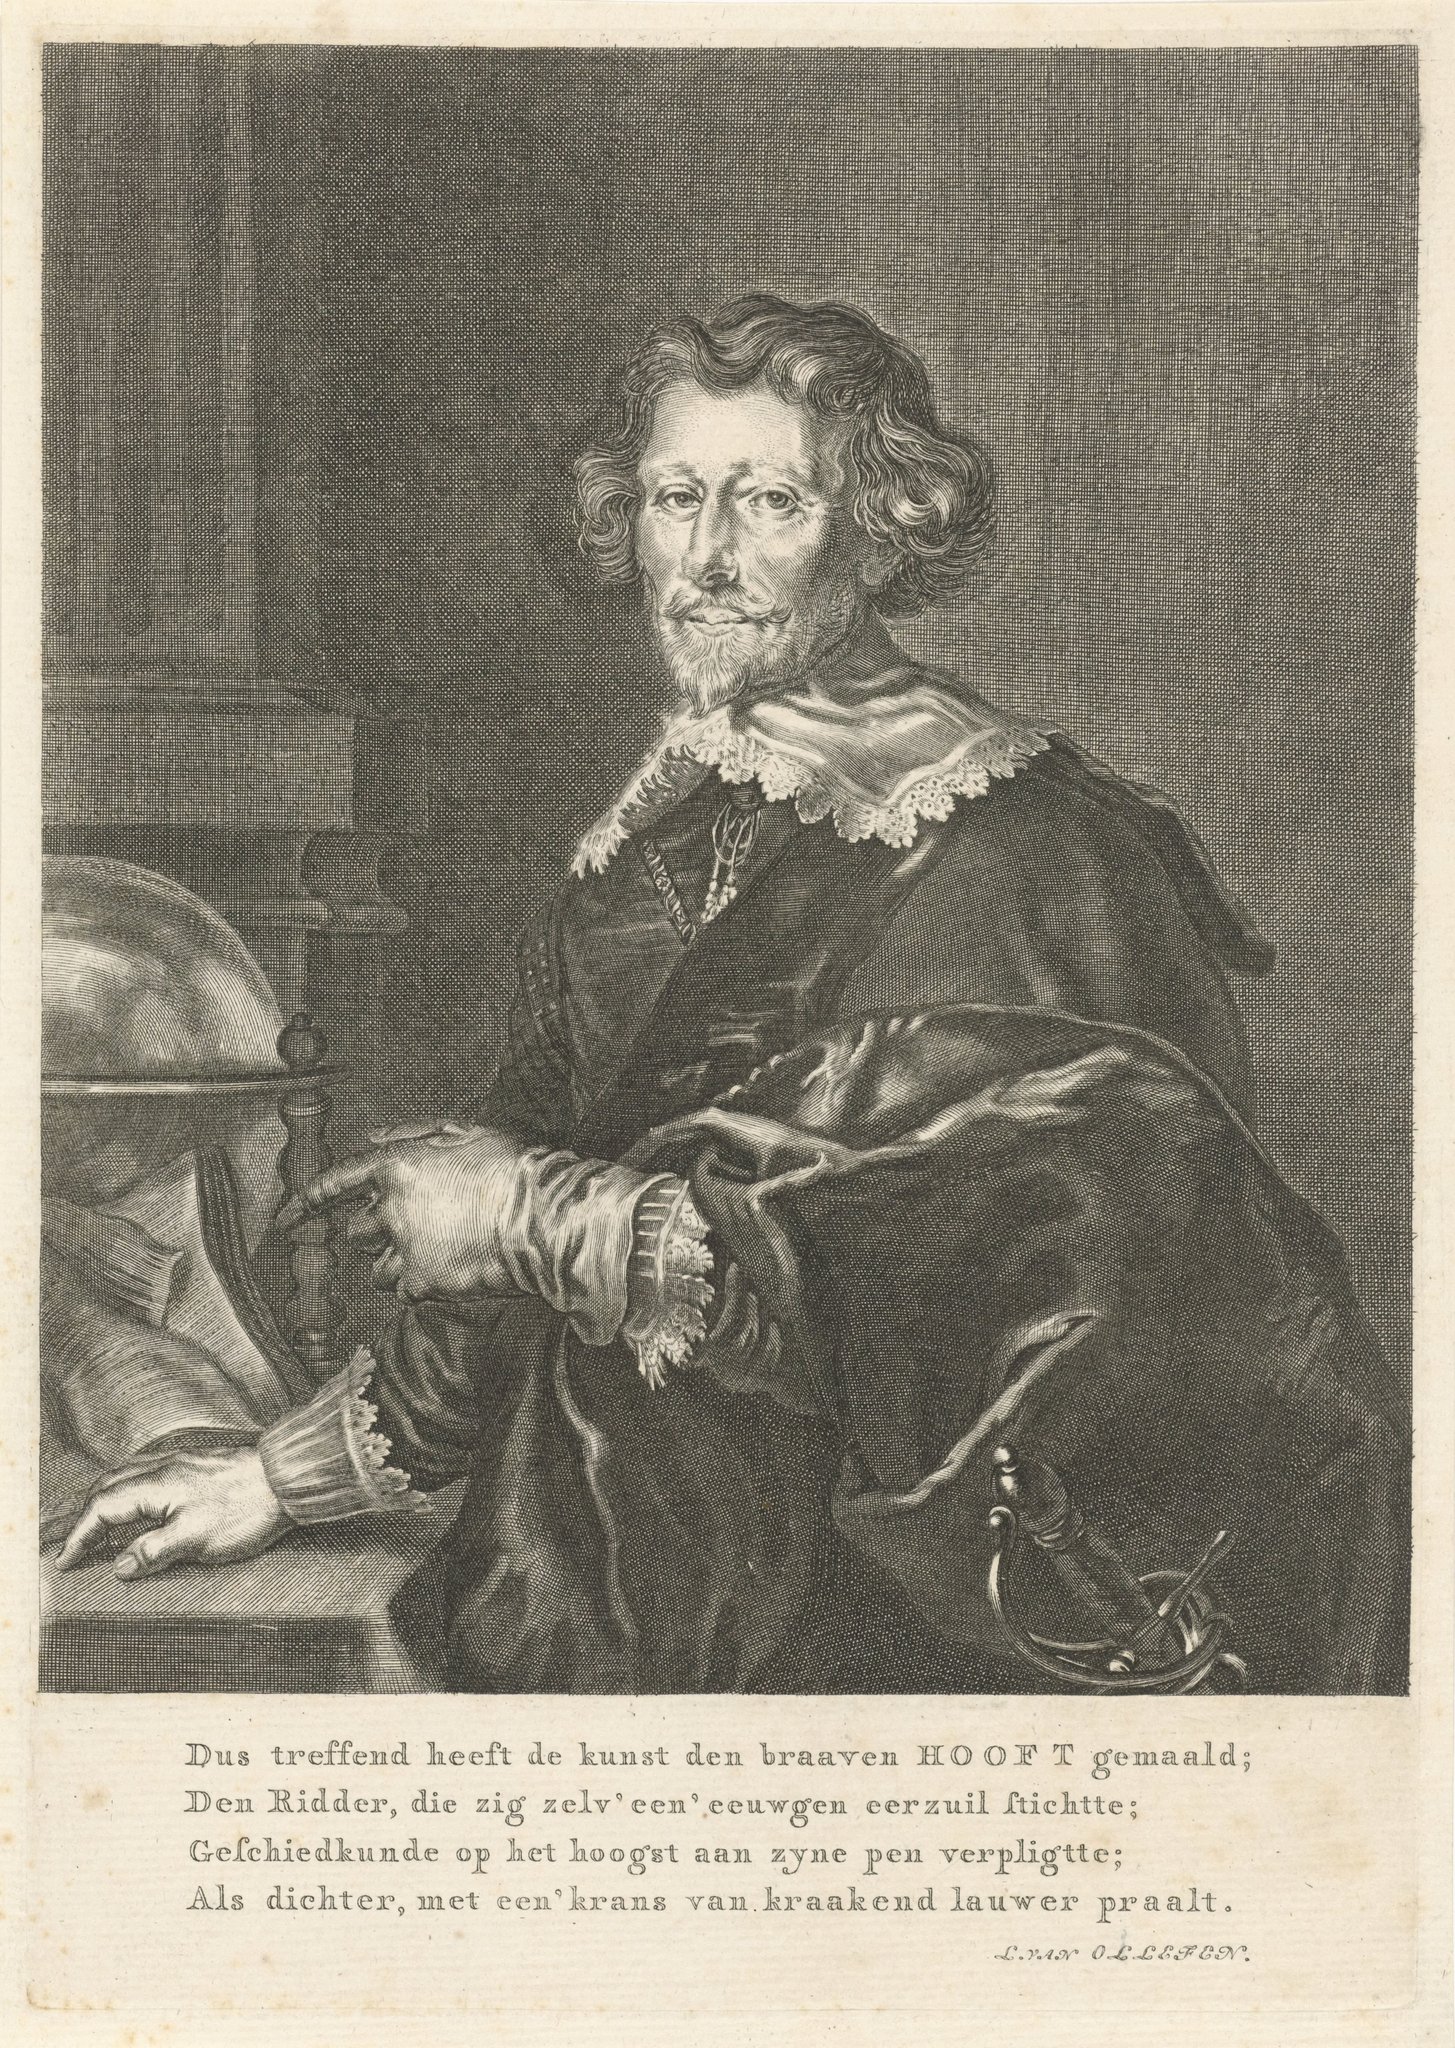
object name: print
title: Portret van Pieter Corneliszoon Hooft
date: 1642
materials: paper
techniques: engraving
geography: amsterdam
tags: the hague, pieter corneliszoon hooft, book - mm - book open, globe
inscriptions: collector's mark: Lugt 2228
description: Portret van de dichter Pieter Corneliszoon Hooft, op 62-jarige leeftijd. Hij wijst op een opengeslagen boek, dat naast een globe op een tafel ligt. In de marge een vierregelig lofdicht in het Nederlands.